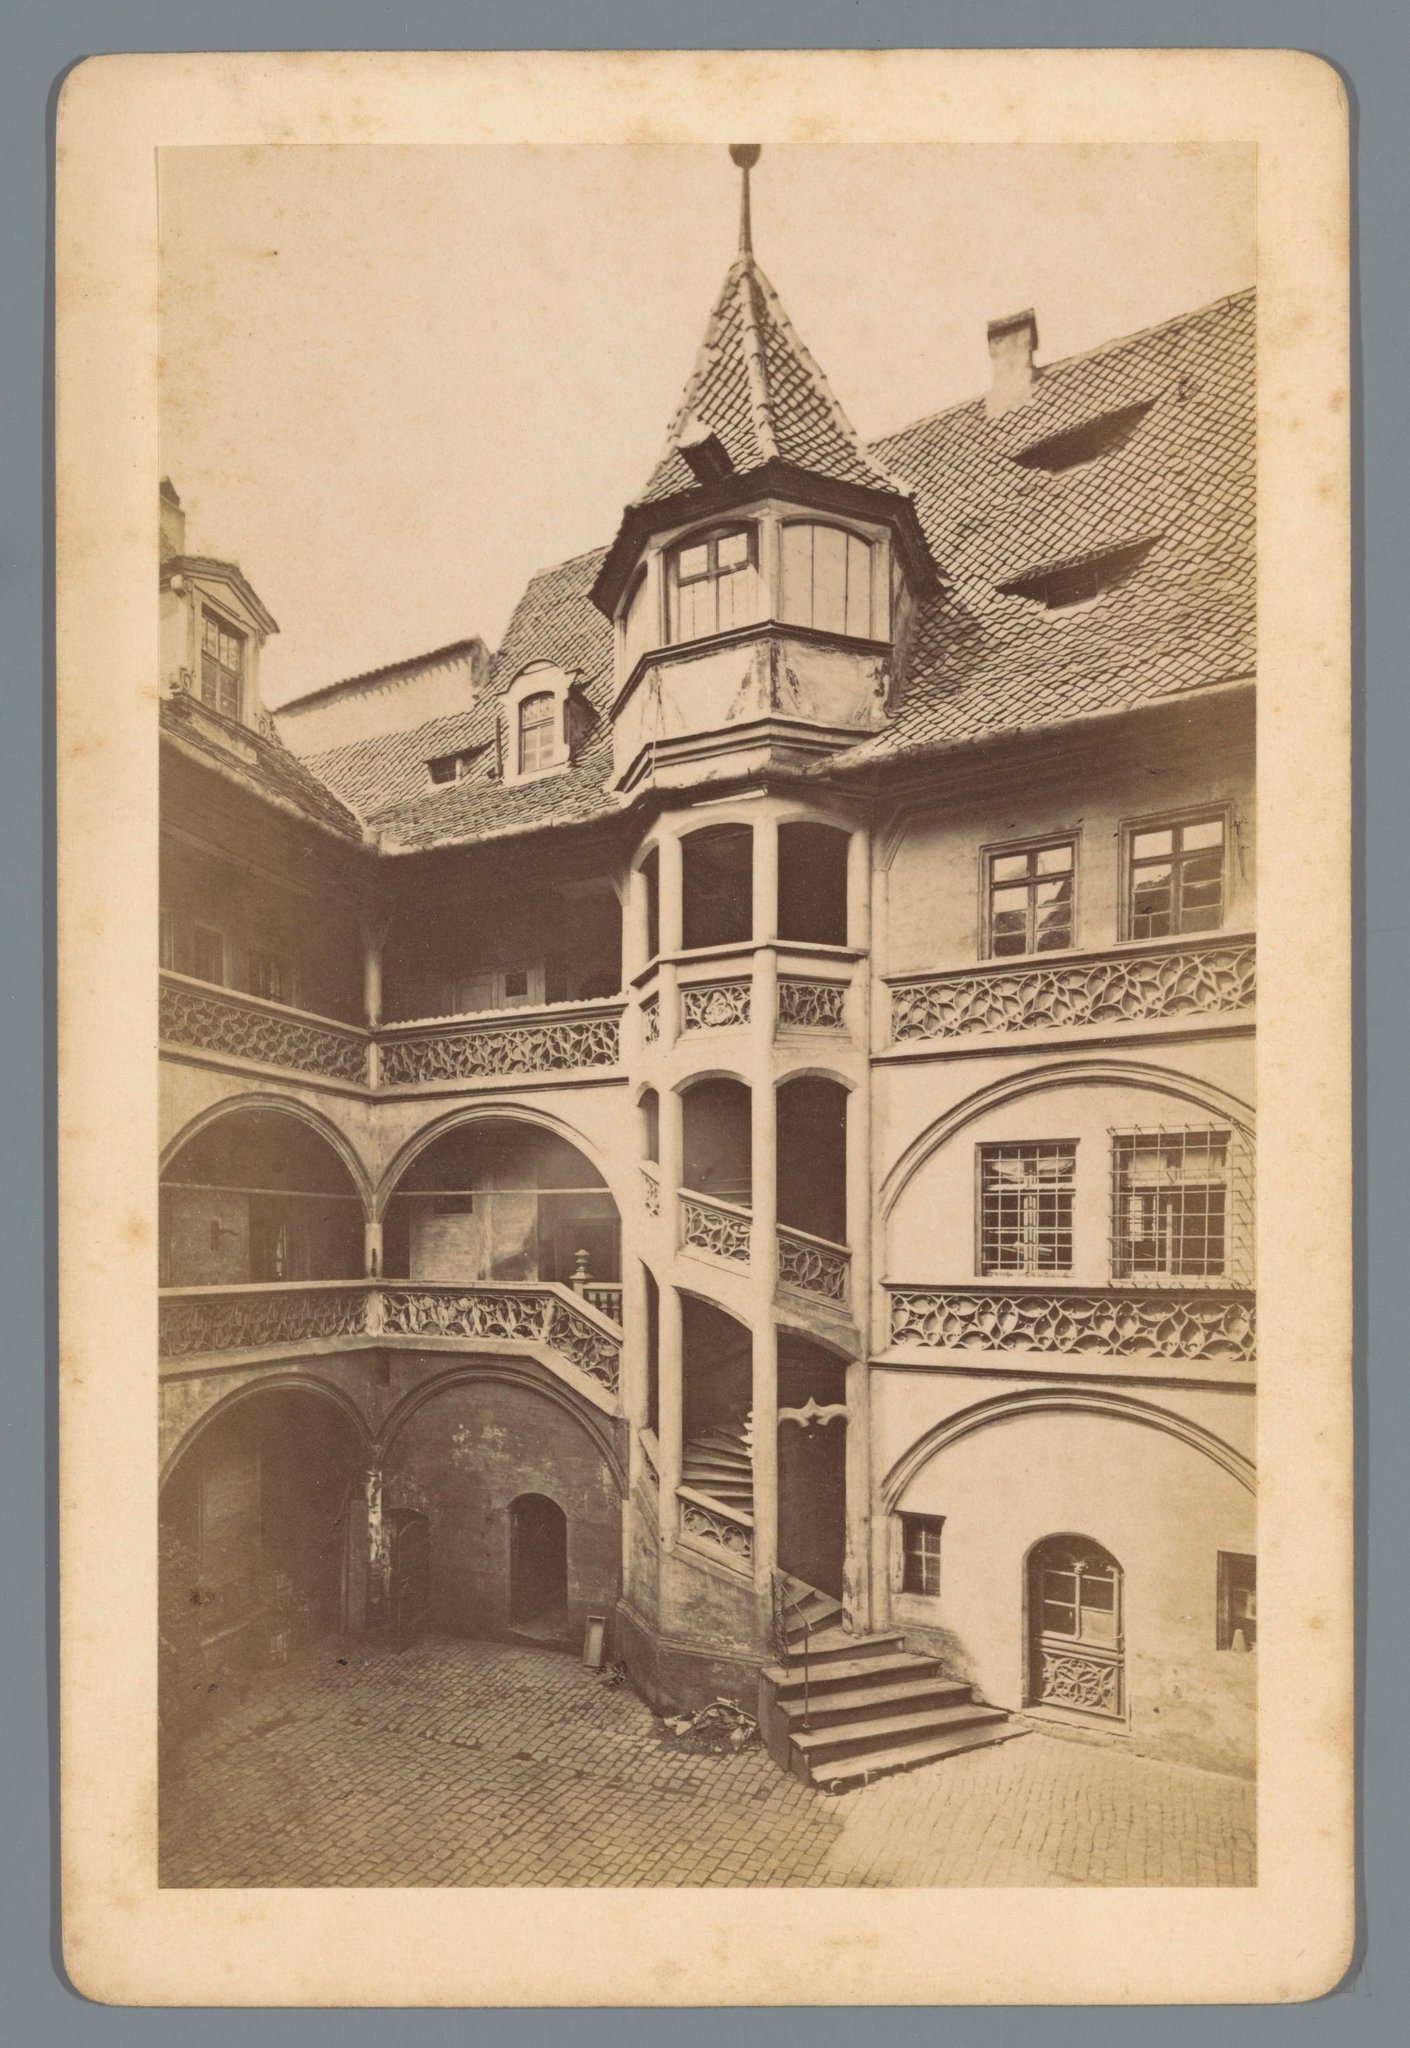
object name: cabinet photograph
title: Nürnberg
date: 1863-1898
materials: cardboard, photographic support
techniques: albumen print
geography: nuremberg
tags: courtyard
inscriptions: number: ‘22.’